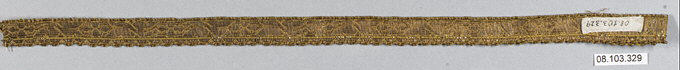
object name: galloon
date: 1701-1800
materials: metal thread